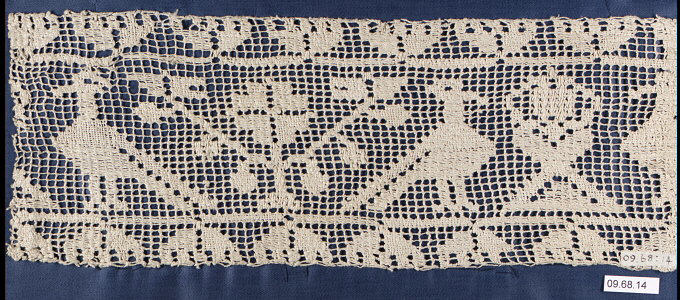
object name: border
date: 1501-1700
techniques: embroidery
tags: birds,flowers